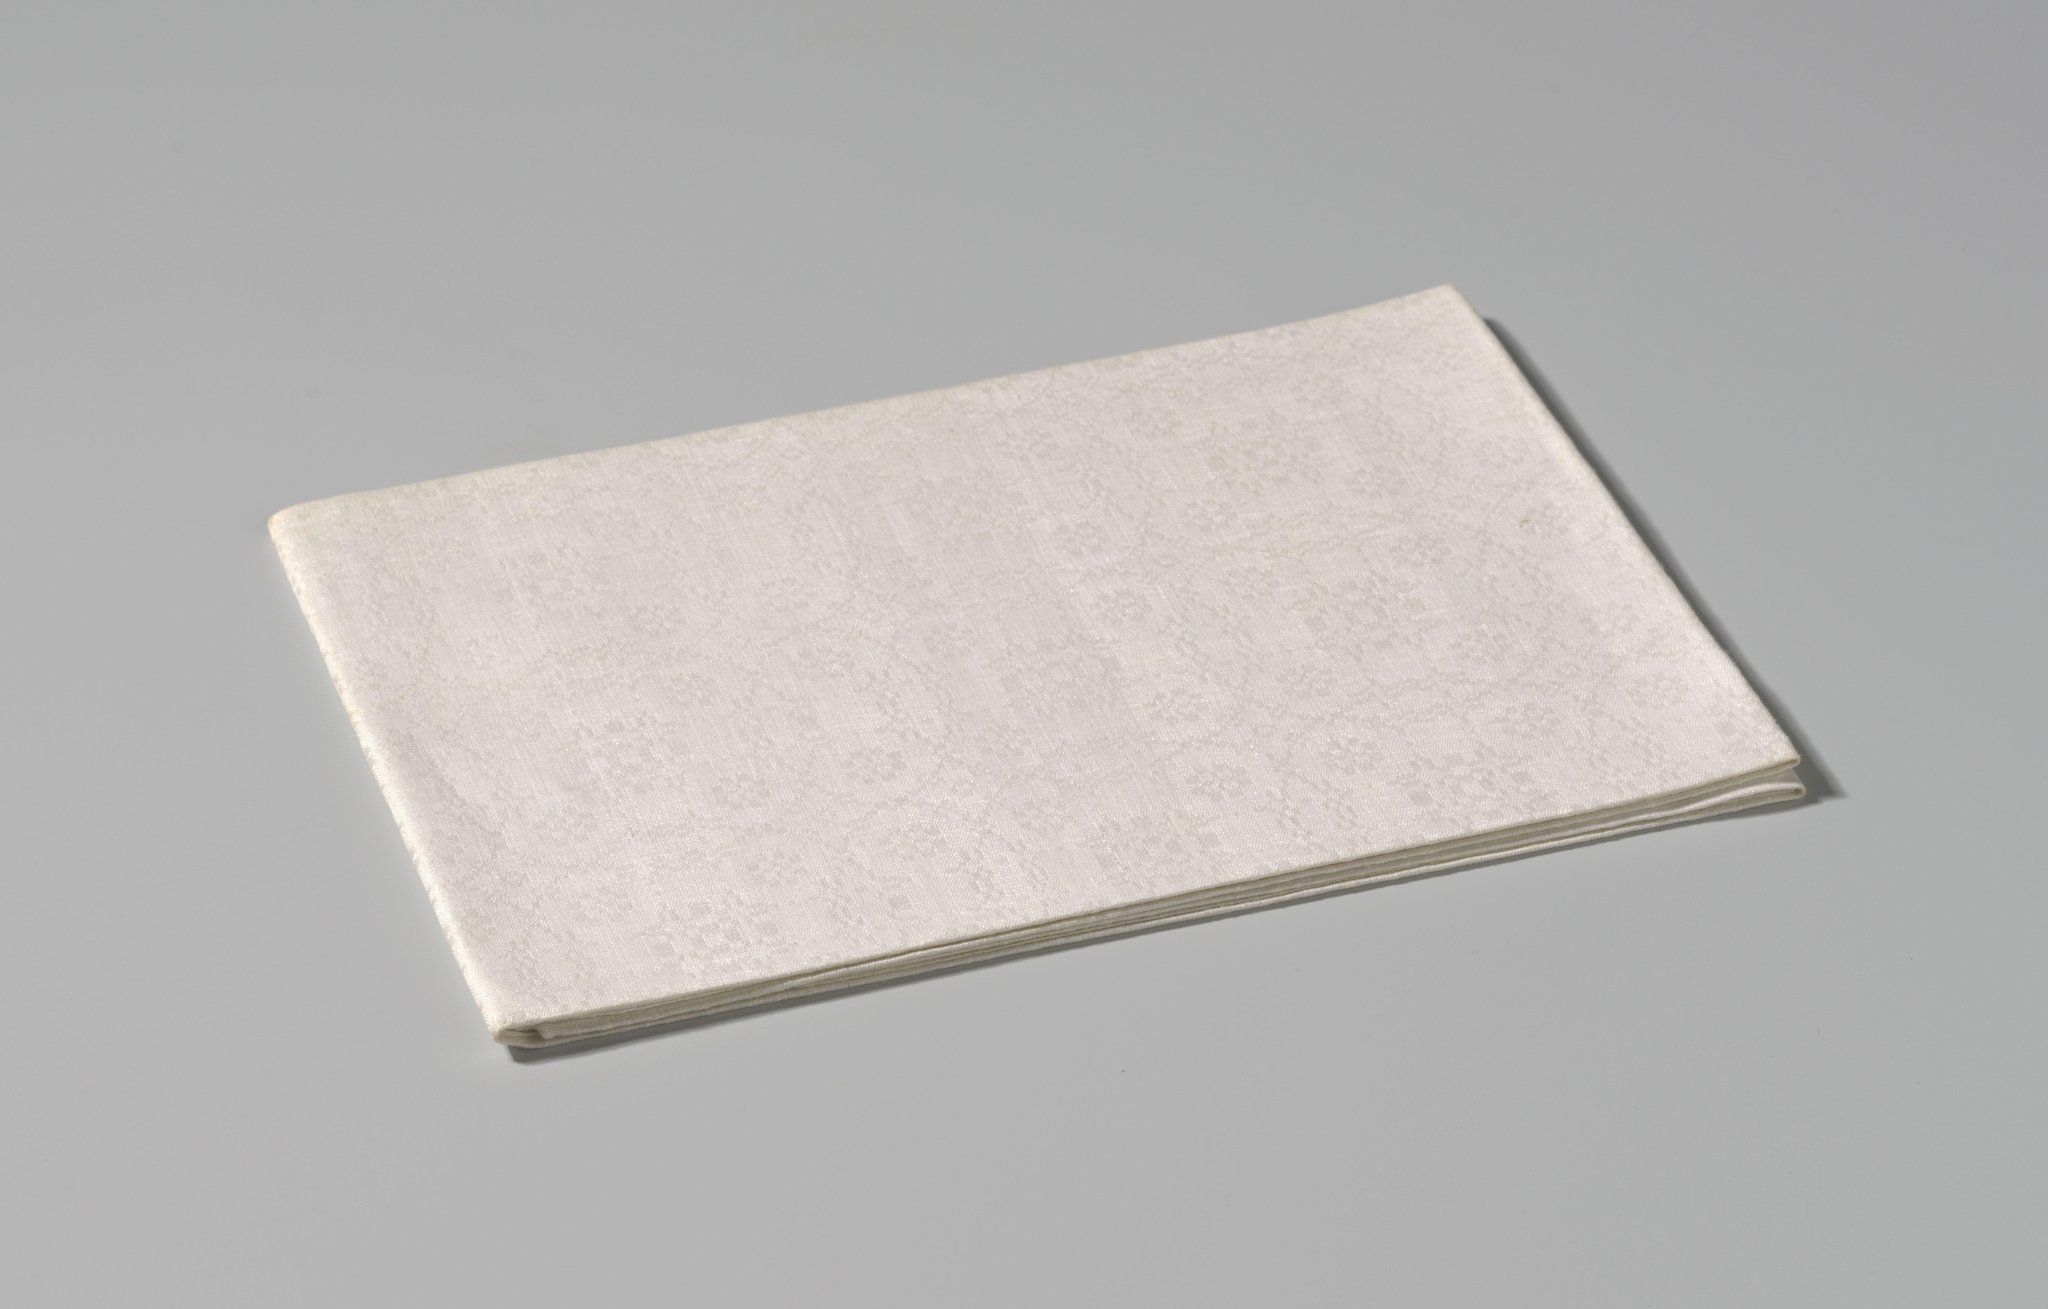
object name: napkin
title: Servet van linnen met pellenpatroon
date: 1690-1728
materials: linen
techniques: peeled fabric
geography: northern netherlands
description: wit linnen servet met pellen patroon, merk TC en 18